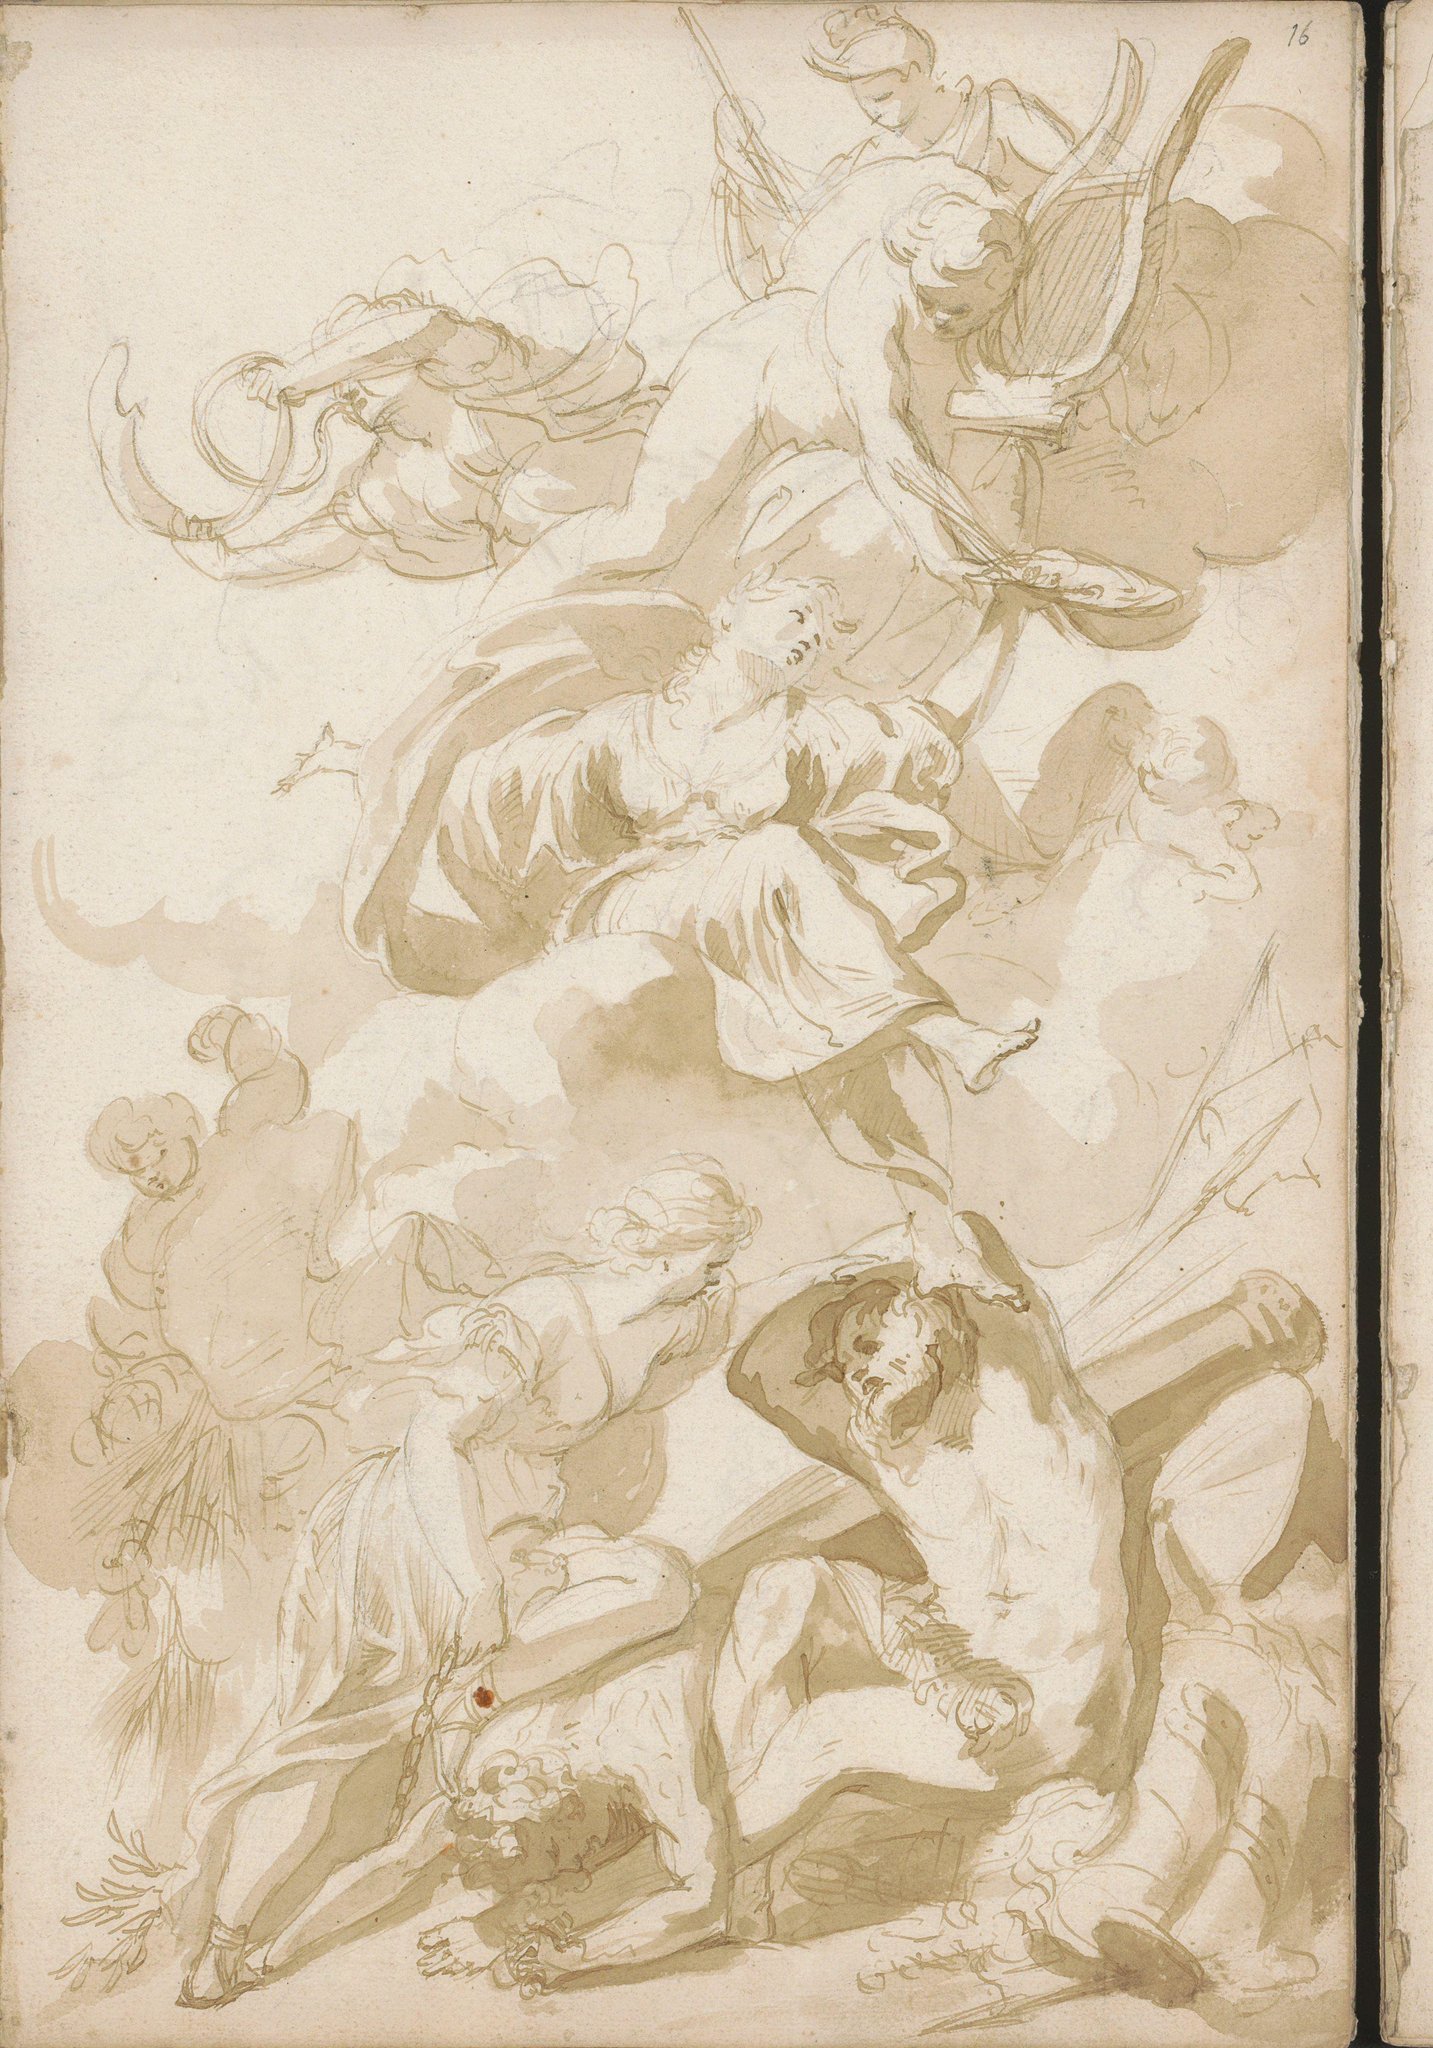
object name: sketchbook leaf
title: Allegorische voorstelling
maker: Anonymous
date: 1650-1799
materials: ink, paper, pencil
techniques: brush, pen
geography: italy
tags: 'pictura', symbolic representations, allegories and emblems ~ painting; 'pittura' (ripa)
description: Combinatie van verschillende allegorische voorstellingen waaronder een allegorie op de kunst(en) met een vrouw met palet en penselen en een man met een luit. Tevens twee geketende (mogelijk gefolterde) mannen zittend en liggend bij een pilaar. Bladzijde 16 uit een schetsboek met 72 bladzijden.